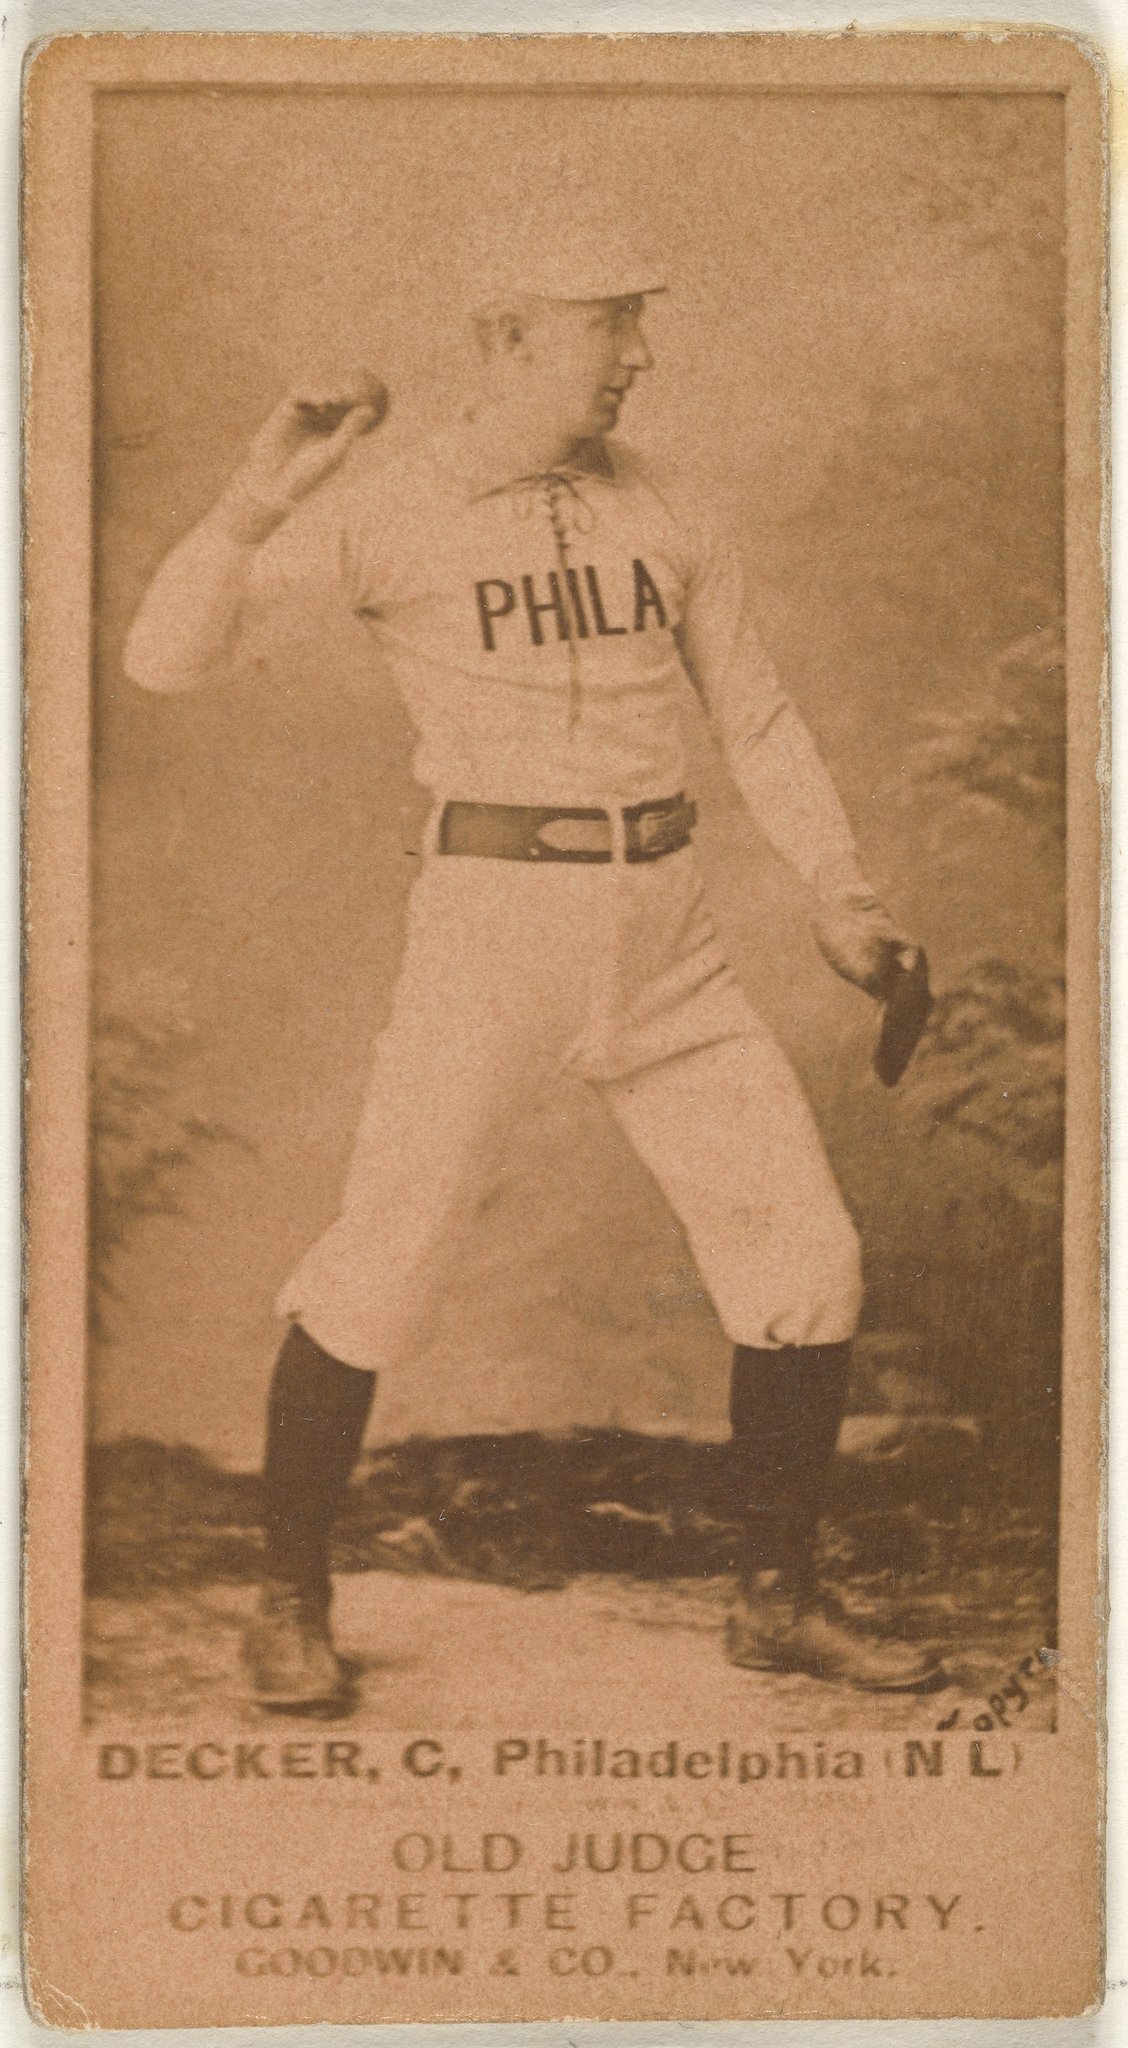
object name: baseball card, photograph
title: Decker, Catcher, Philadelphia, from the Old Judge series (N172) for Old Judge Cigarettes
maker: goodwin & company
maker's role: publisher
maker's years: 1850-1950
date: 1887-1890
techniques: albumen silver print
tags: men,portraits,baseball,athletes